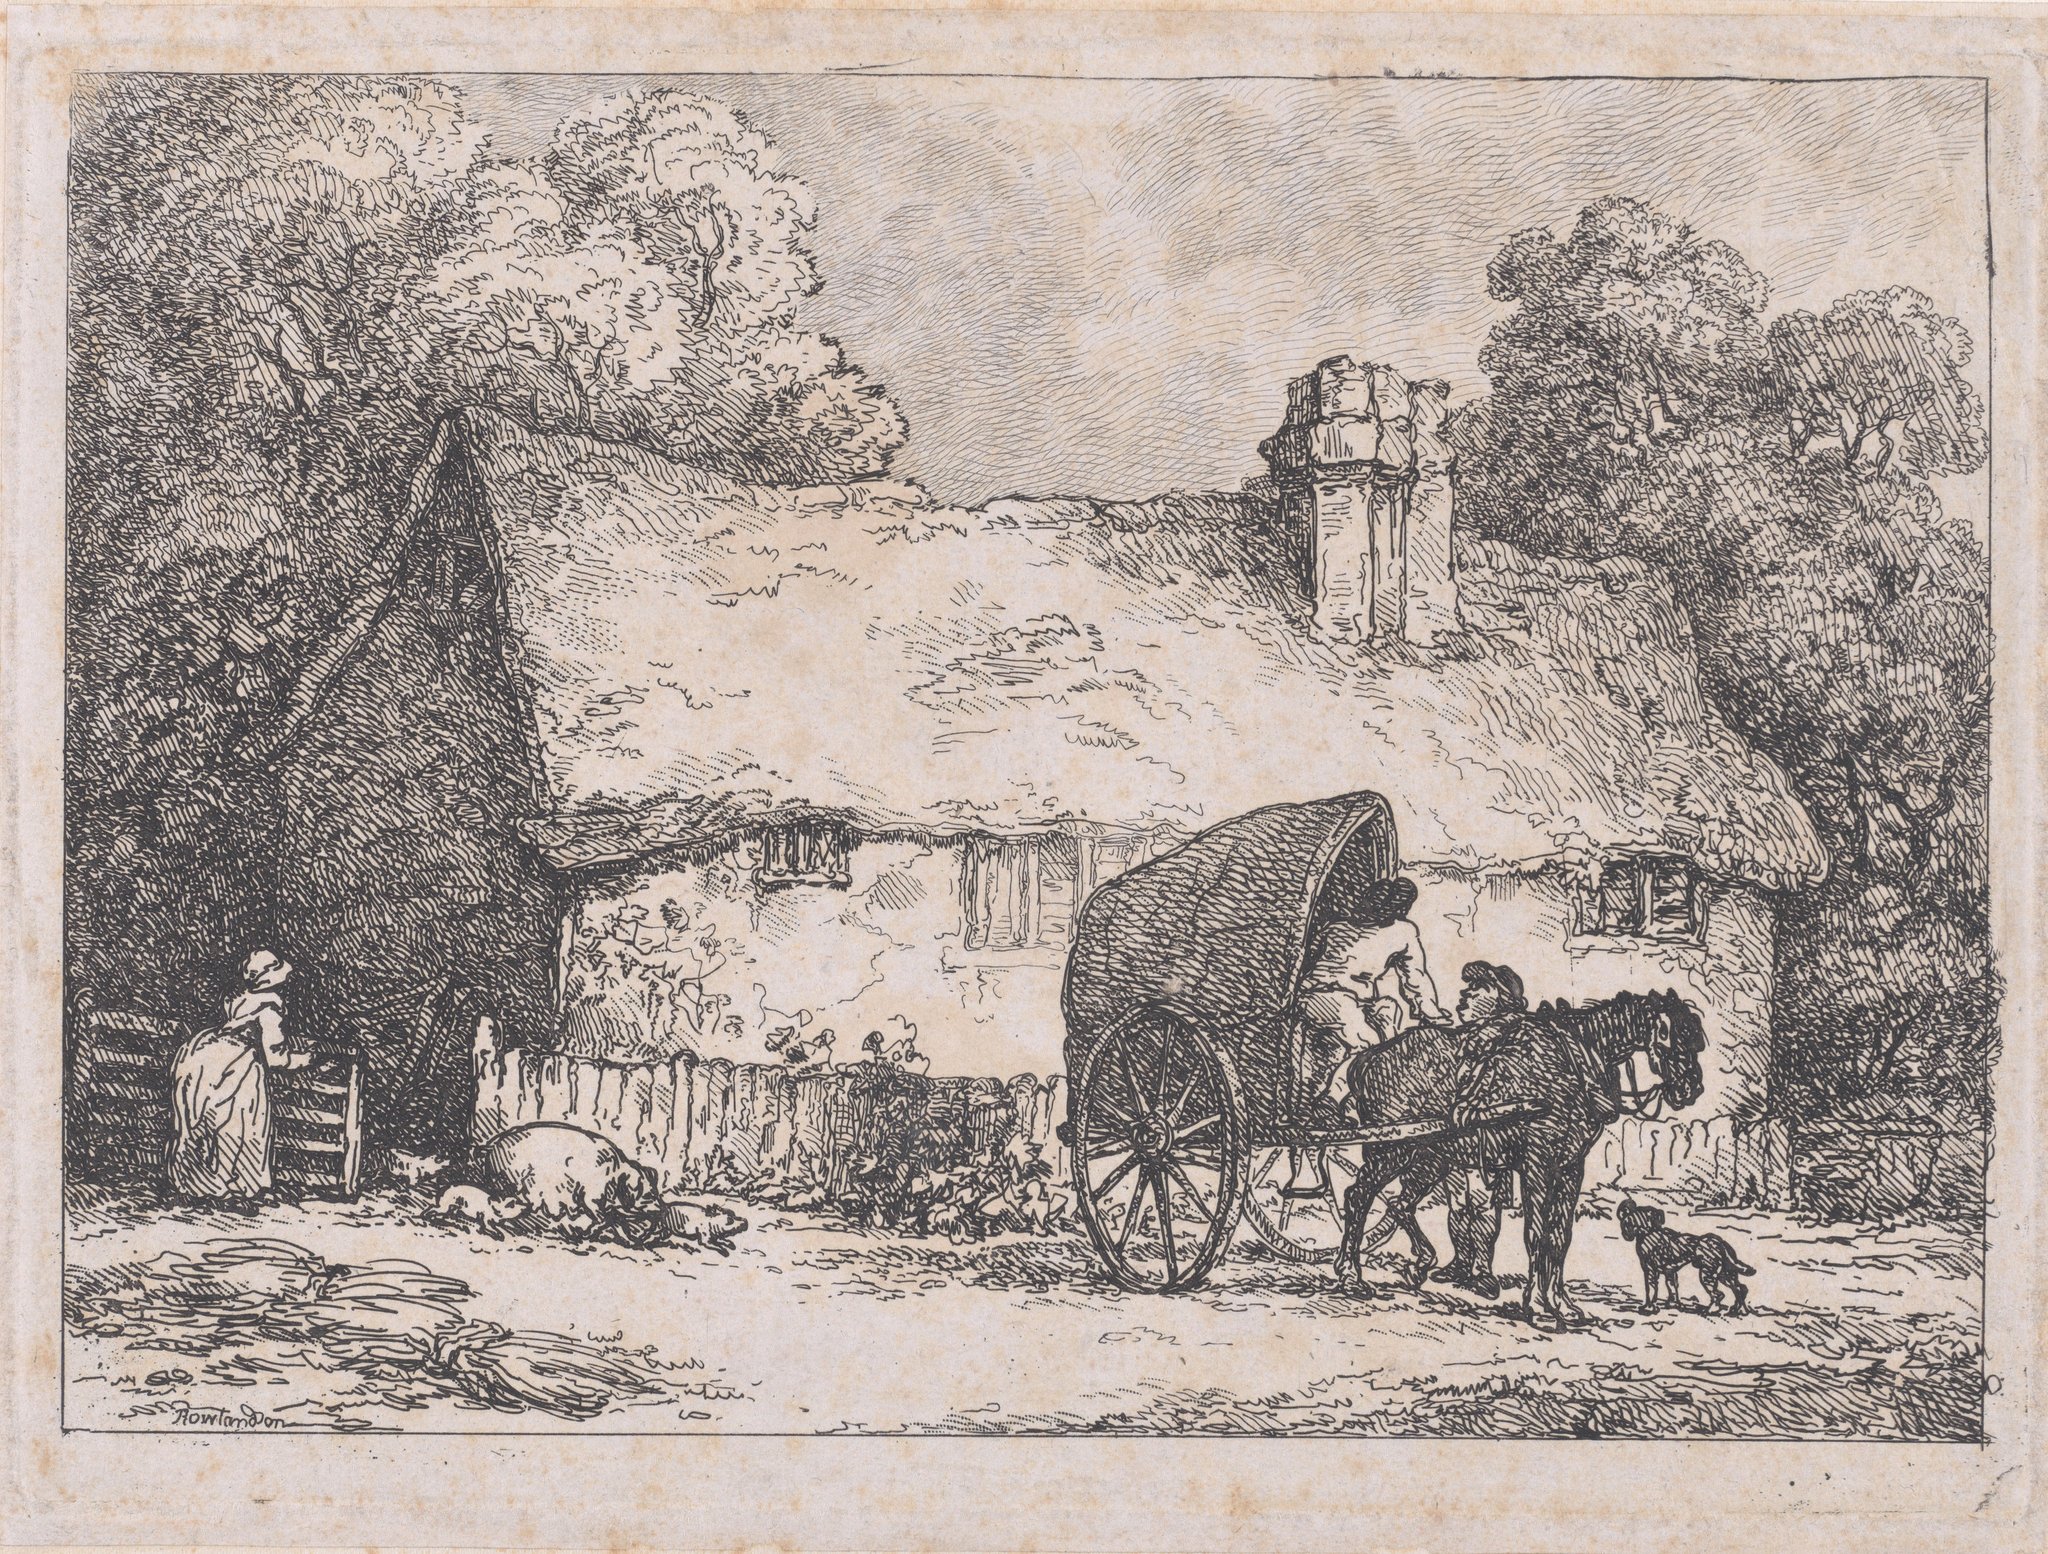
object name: print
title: Cottage with Cart and Pigs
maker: thomas rowlandson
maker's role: artist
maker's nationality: british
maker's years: 1757-1827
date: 1783-1789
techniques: etching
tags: houses,horses,pigs,carts